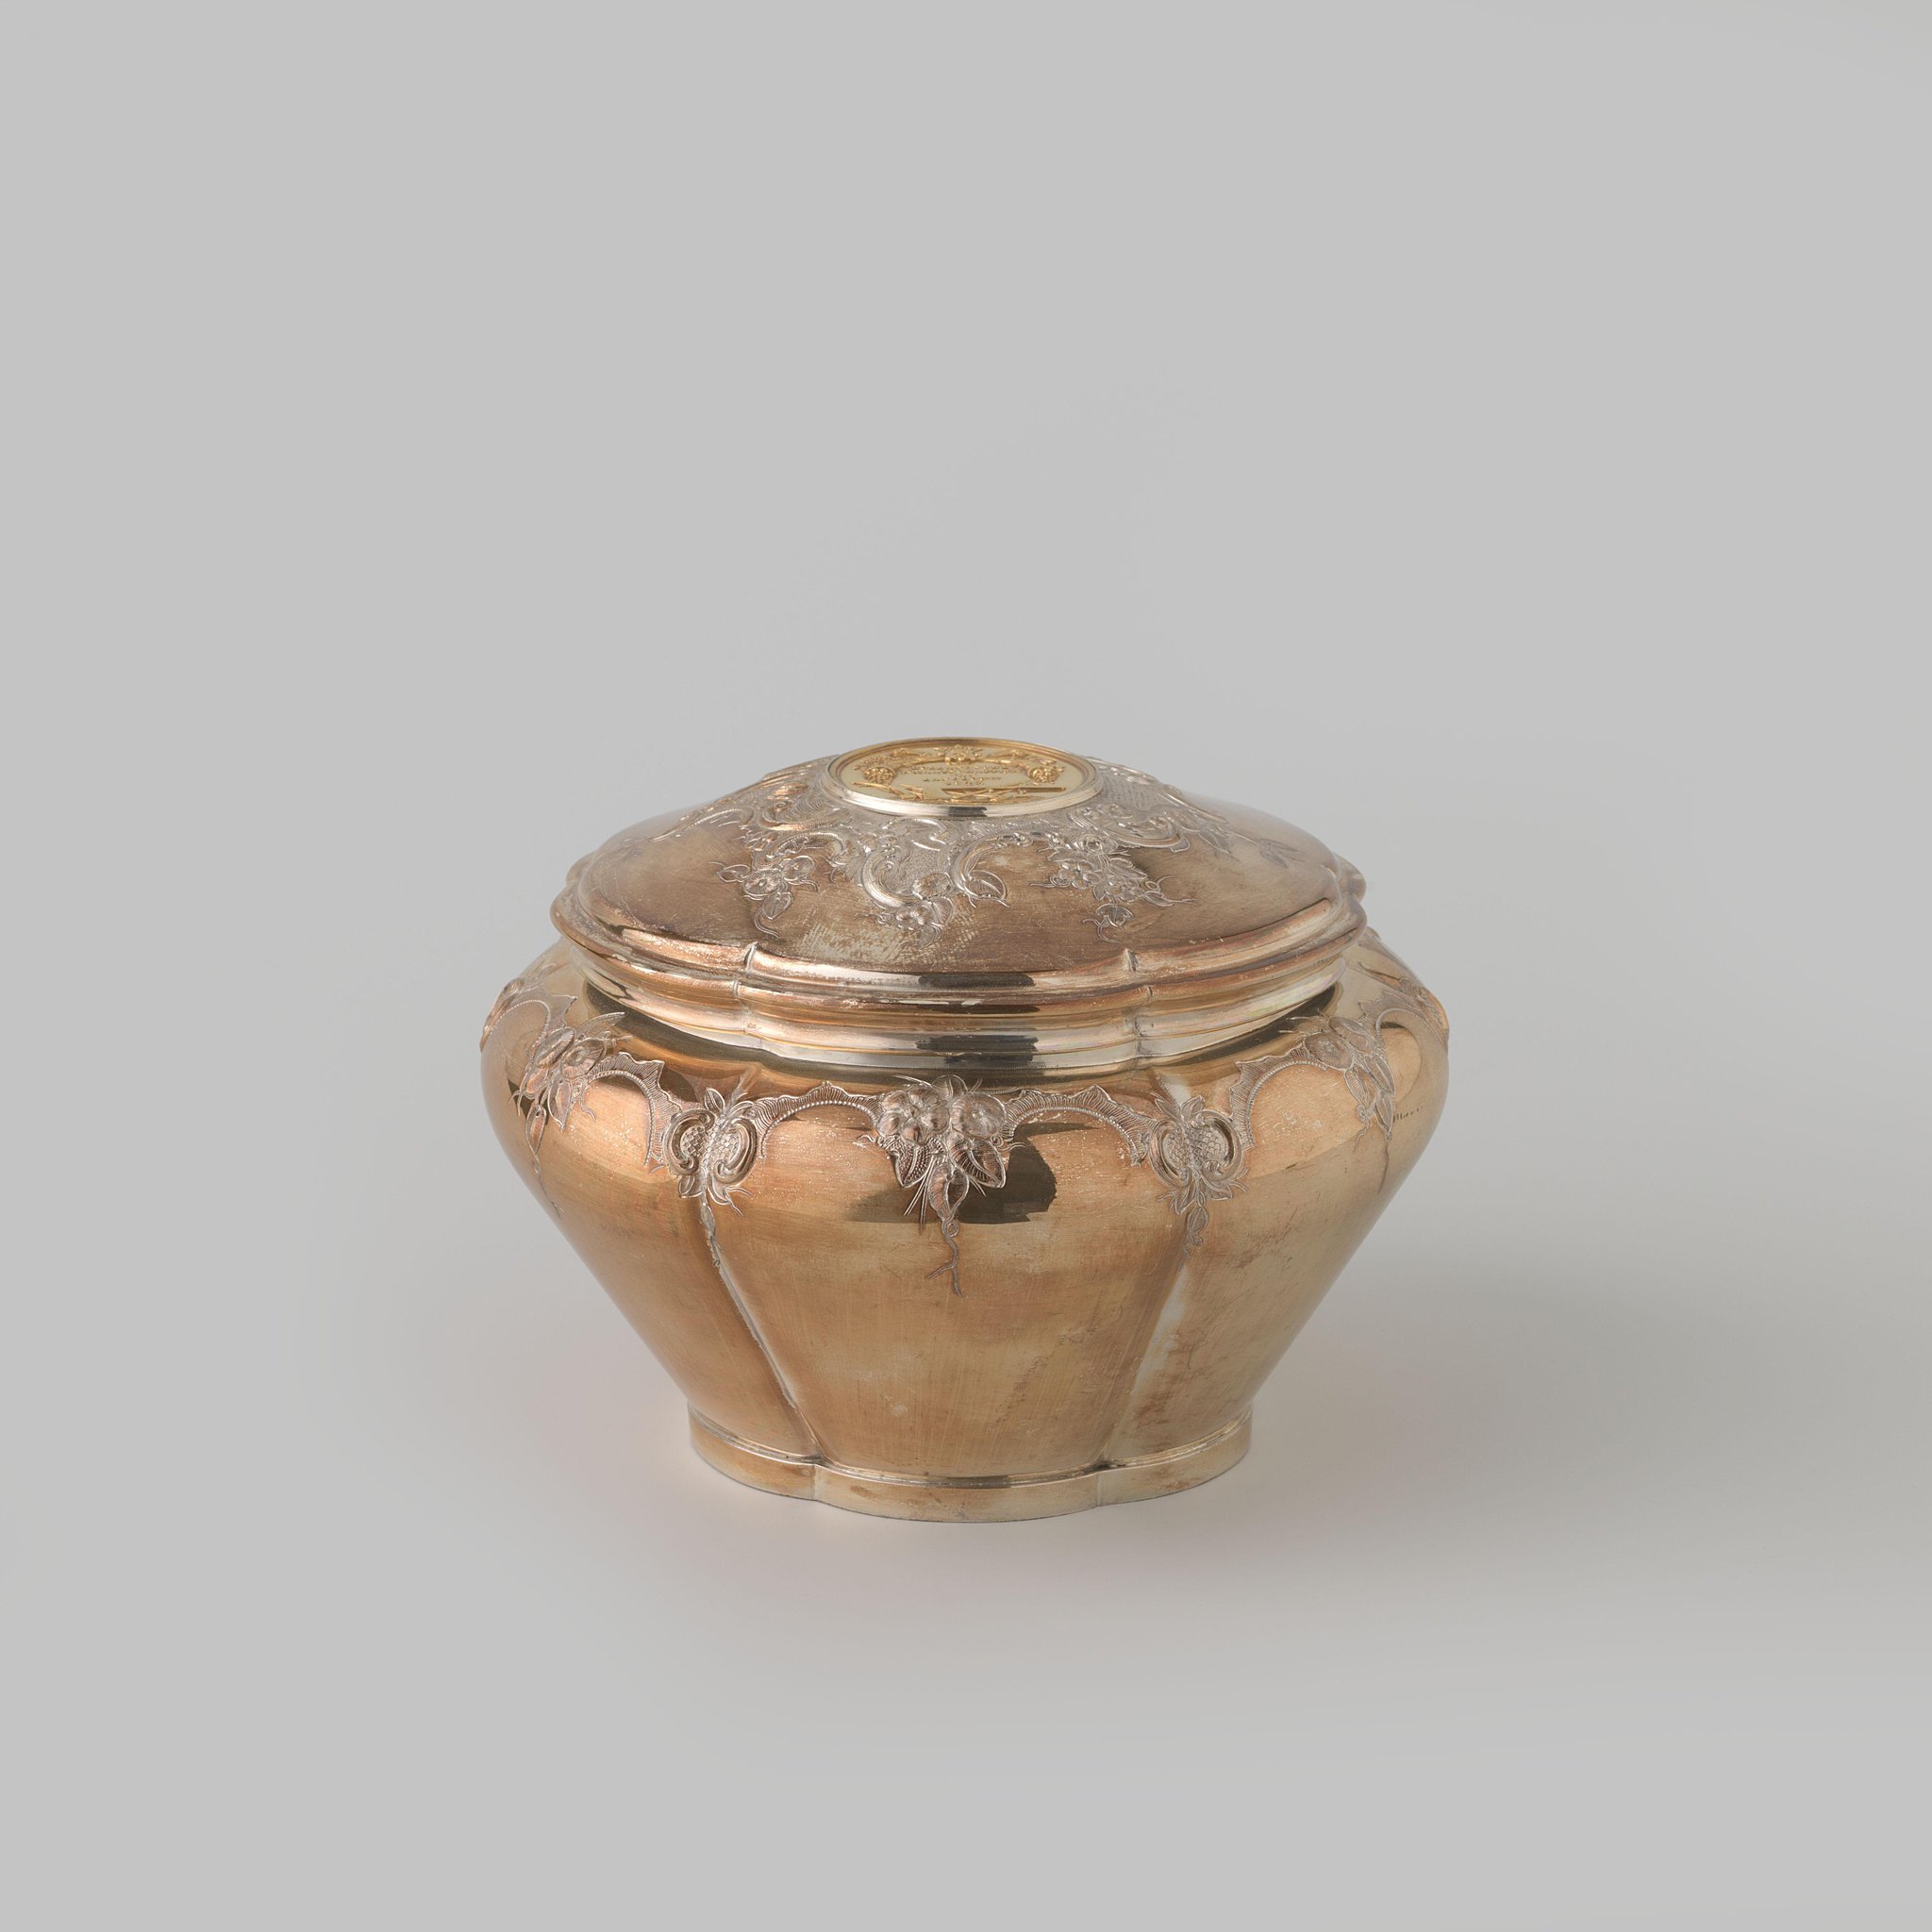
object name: tin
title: Zilveren trommel uit een koffie- en theeservies van elf delen dat toebehoorde aan J.D. Preuijt (1801-1887), aan hem gegeven bij zijn jubileum in 1873.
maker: pieter zöllner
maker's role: silversmith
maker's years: 1806-1894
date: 1859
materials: gold, silver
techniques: engraving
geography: rotterdam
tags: geervliet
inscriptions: date letter: ‘z’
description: Zilveren ronde trommel met scharnierend deksel versierd met blo emenmotieven. Zonder poten. In het deksel is vast ingelegd een gouden penning. De penning is van de Hollandsche Maatschappij voor Landbouw (1847). 'Aan J.D. Preuijt/voor/de/schoonste/vetgeweide/koe/Haarlem/1952.'